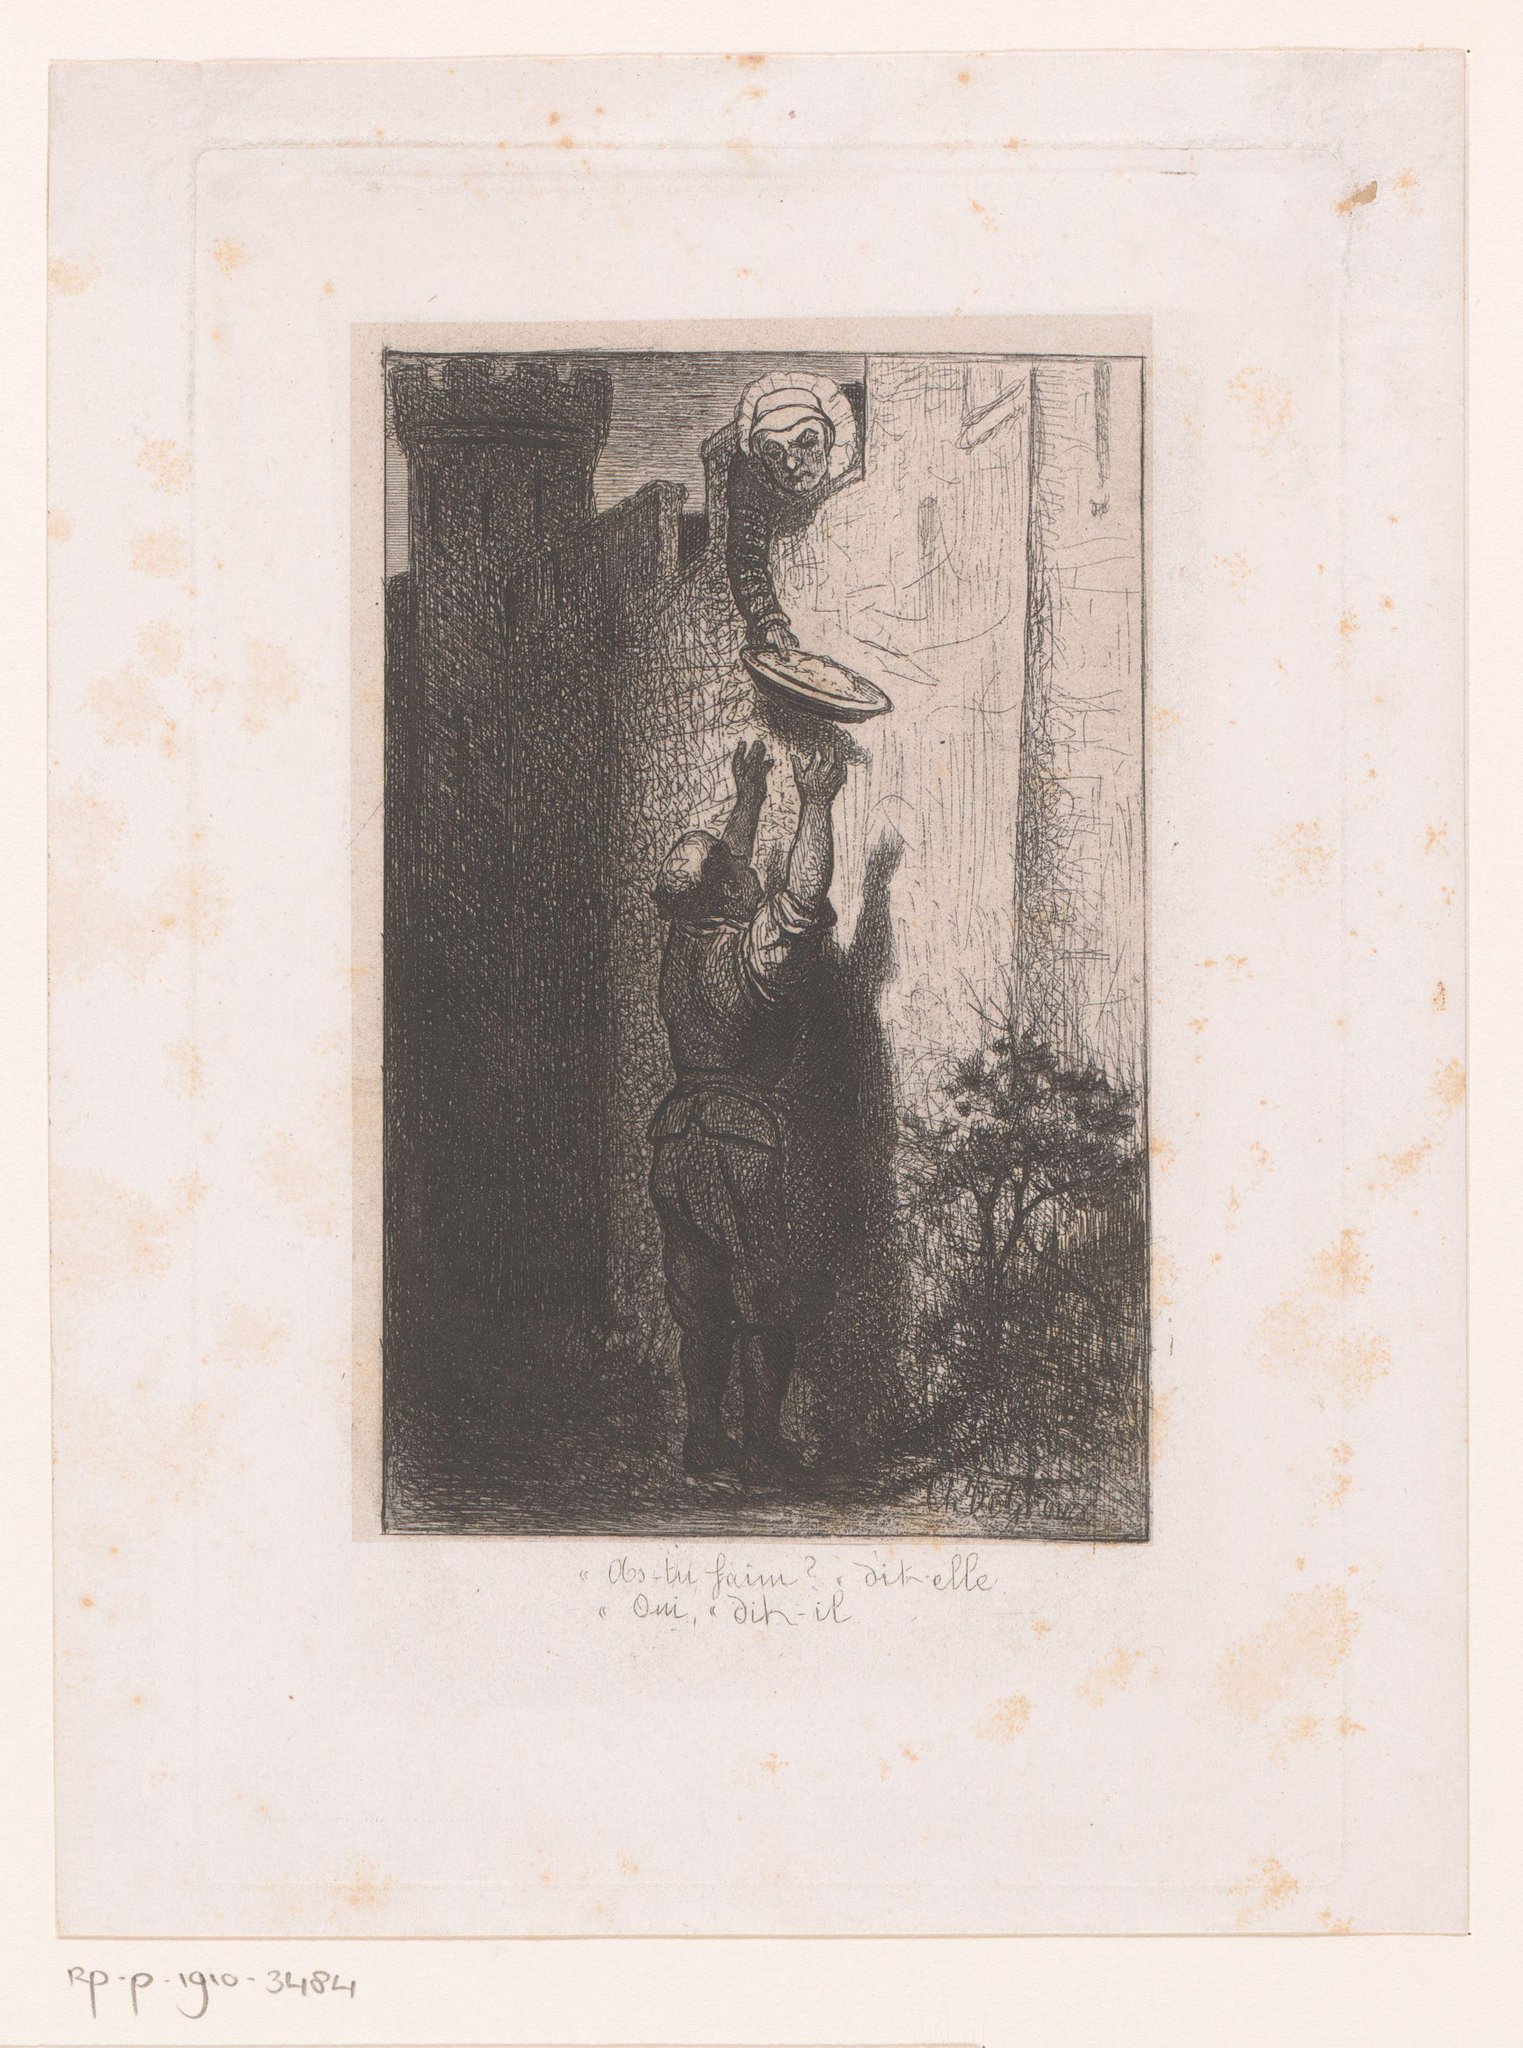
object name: book illustration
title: "As-tu faim?" dit-elle. "Oui," dit-il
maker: charles de groux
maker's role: painter, print maker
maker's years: 1825-1870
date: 1861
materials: paper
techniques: etching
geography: paris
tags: giving alms or other charity, e.g.: handing out food, battlement, crenellation ~ fortified city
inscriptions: collector's mark: Lugt 2228, collector's mark: Lugt 1485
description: Prent uit: Coster, Charles de. Légendes Flamandes. 1e druk. Brussel: Veuve Parent & Fils, Parijs: Michel-Lévy, Leipzig: Ch. Muquardt, 1861, p. 232-233. De prent illustreert het verhaal Smetse Smee.